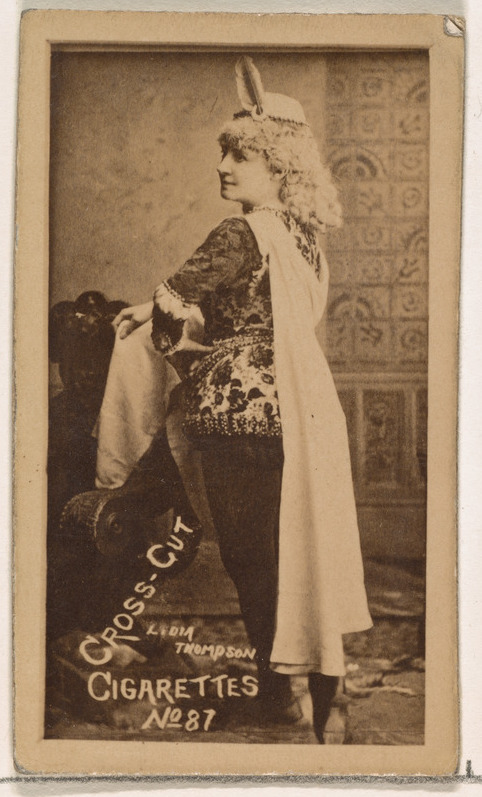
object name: print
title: Card Number 87, Lydia Thompson, from the Actors and Actresses series (N145-1) issued by Duke Sons & Co. to promote Cross Cut Cigarettes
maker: w. duke, sons & co.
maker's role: publisher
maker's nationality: american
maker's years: 1870-1920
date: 1880-1889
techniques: albumen silver print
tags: profiles,women,actresses